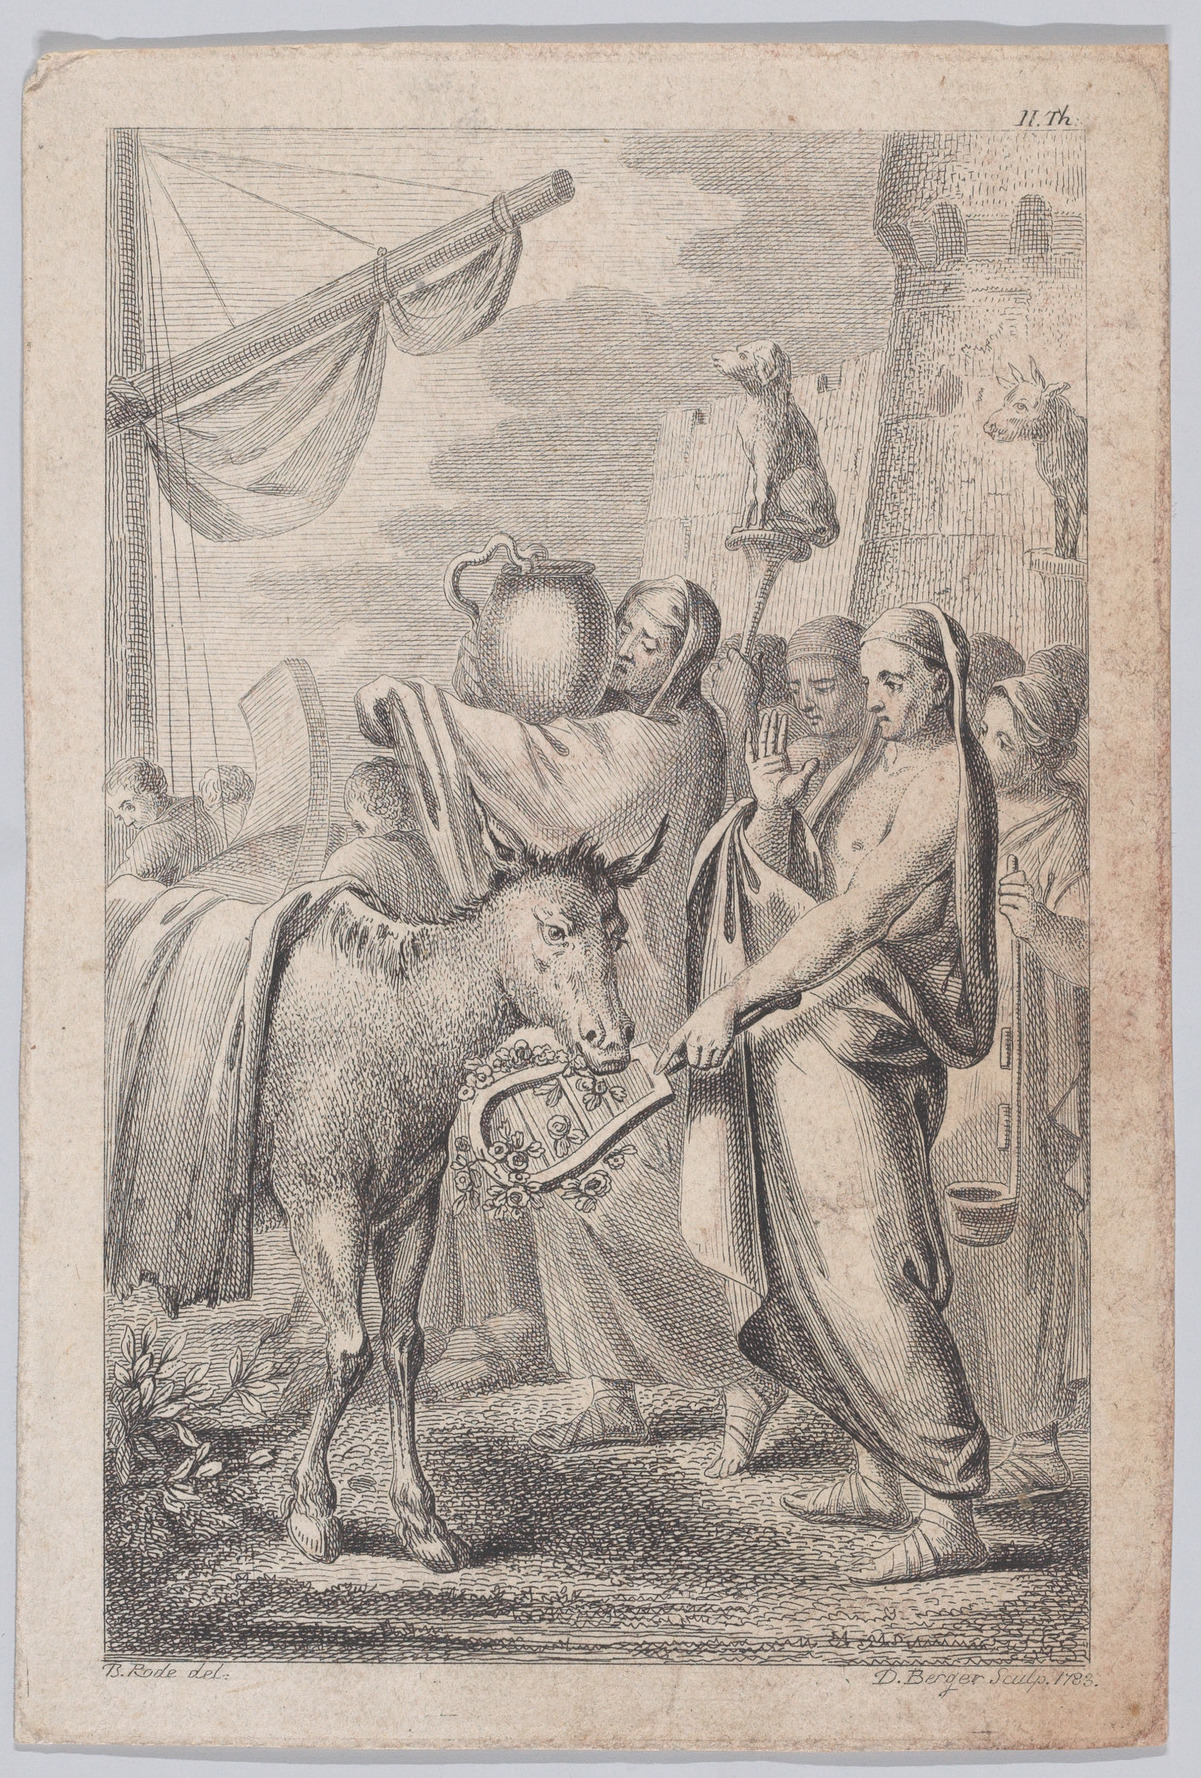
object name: print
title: Figures at right near a ship, some holding up animals over their heads, a horse at left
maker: daniel berger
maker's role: print maker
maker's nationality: german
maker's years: 1744-1824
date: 1783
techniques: engraving, etching